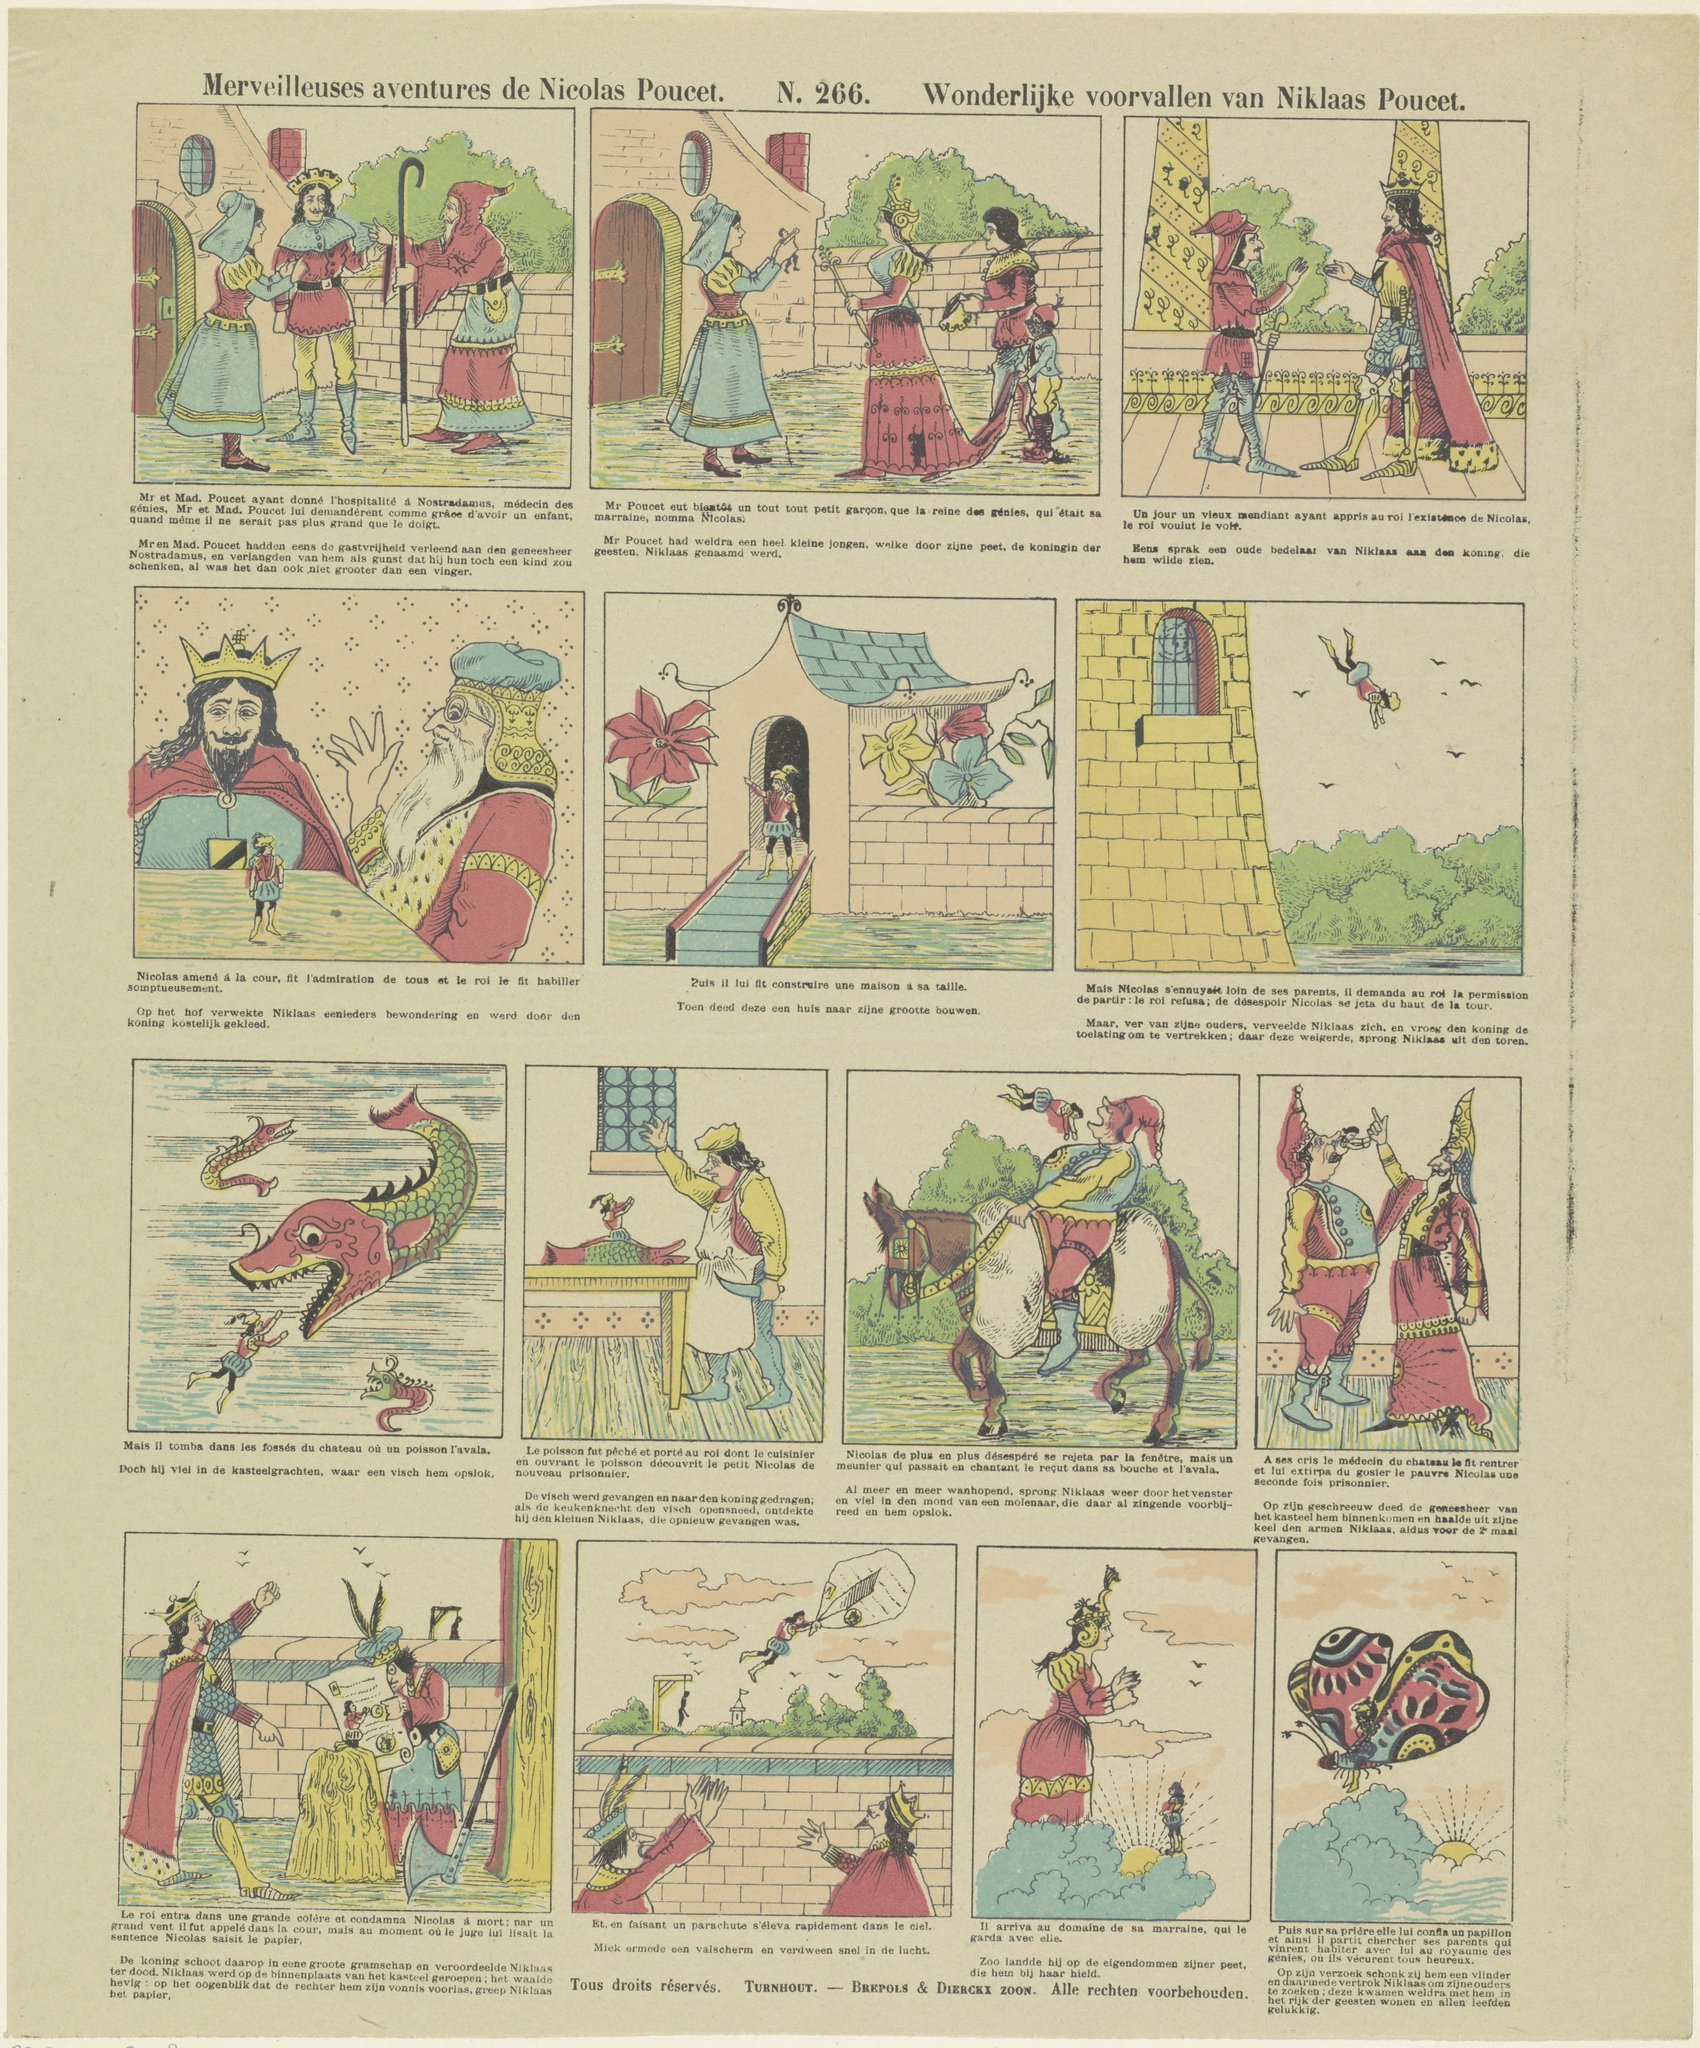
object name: popular print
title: Merveilleuses aventures de Nicolas Poucet / Wonderlijke voorvallen van Niklaas Poucet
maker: Anonymous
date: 1833-1911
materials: paper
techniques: lithograph, letterpress printing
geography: turnhout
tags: tales and fairy tales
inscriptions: collector's mark: Lugt 2760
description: Blad met 14 voorstellingen over de wonderlijke avonturen van Niklaas Poucet. Onder elke afbeelding een onderschrift in het Nederlands en in het Frans. Genummerd midden boven: N. 266.